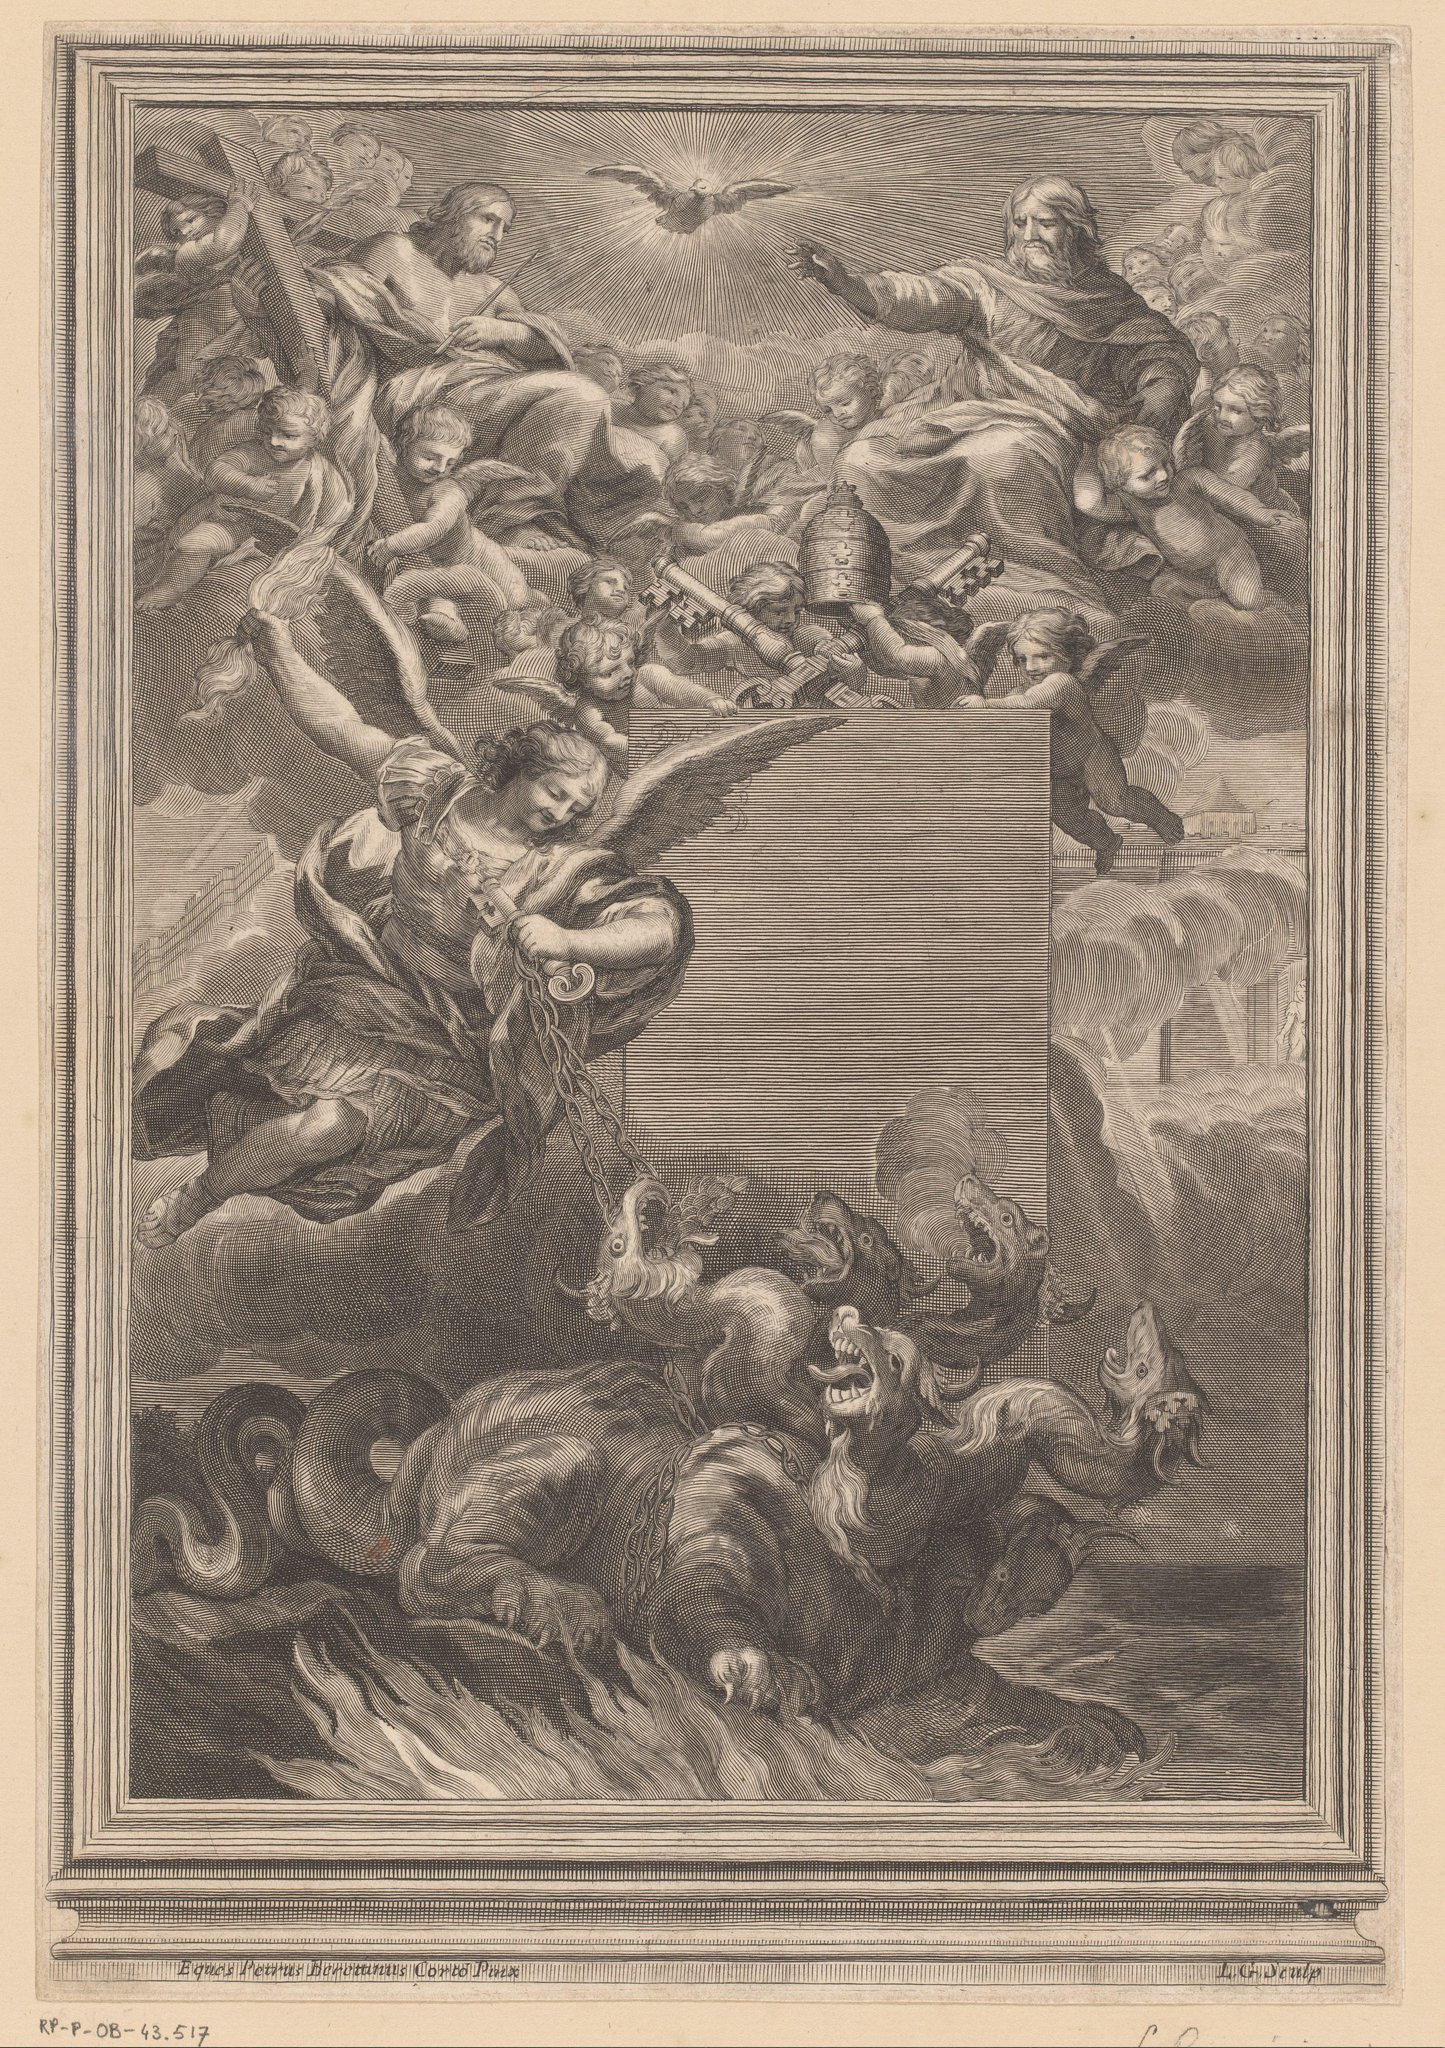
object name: print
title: Aartsengel Michaël met een zeskoppige draak en de Heilige Drie-eenheid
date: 1685-1750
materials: paper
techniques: engraving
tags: the archangel michael fighting the dragon (devil, satan), the holy trinity, 'trinitas coelestis'; father, son and holy ghost ~ christian religion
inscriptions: collector's mark: Lugt 240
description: De aartsengel Michaël in gevecht met een zeskoppige draak. Boven op wolken zitten Christus en God de Vader, omringd door putti. Midden boven zweeft de Heilige Geest in de gedaante van een duif. Op de achtergrond een poort met een engel.